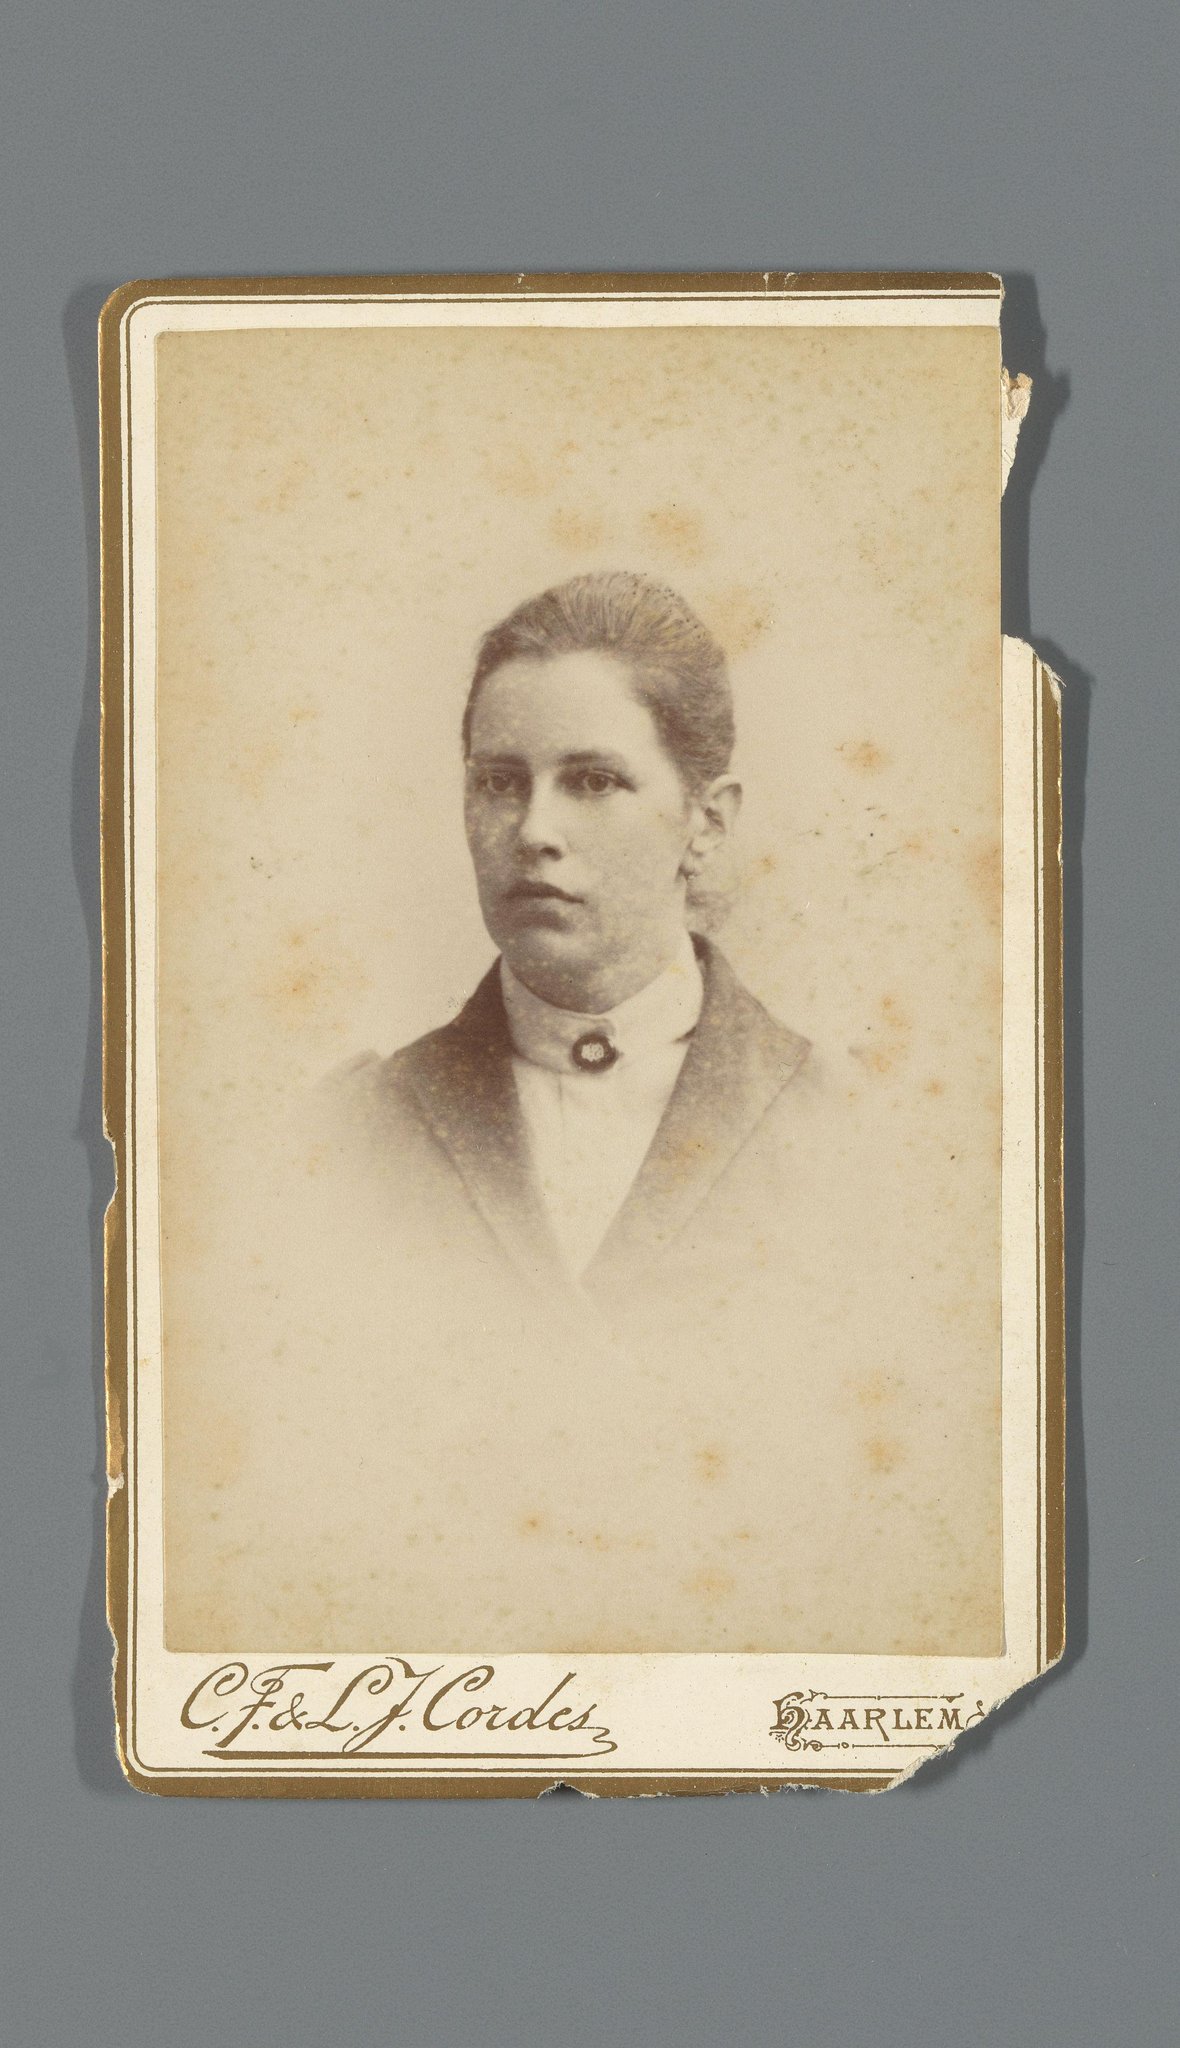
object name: photograph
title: Portret van Susanna Jacoba Hermina des Tombe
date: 1870-1890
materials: cardboard, photographic support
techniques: photography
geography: haarlem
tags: haarlem, historical persons - bb - woman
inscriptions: annotation: ‘SJH TvB-des Tombe (Anna des Tombe is haar ongetrouwd gebleven zuster)’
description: Portret van Susanna Jacoba Hermina des Tombe.